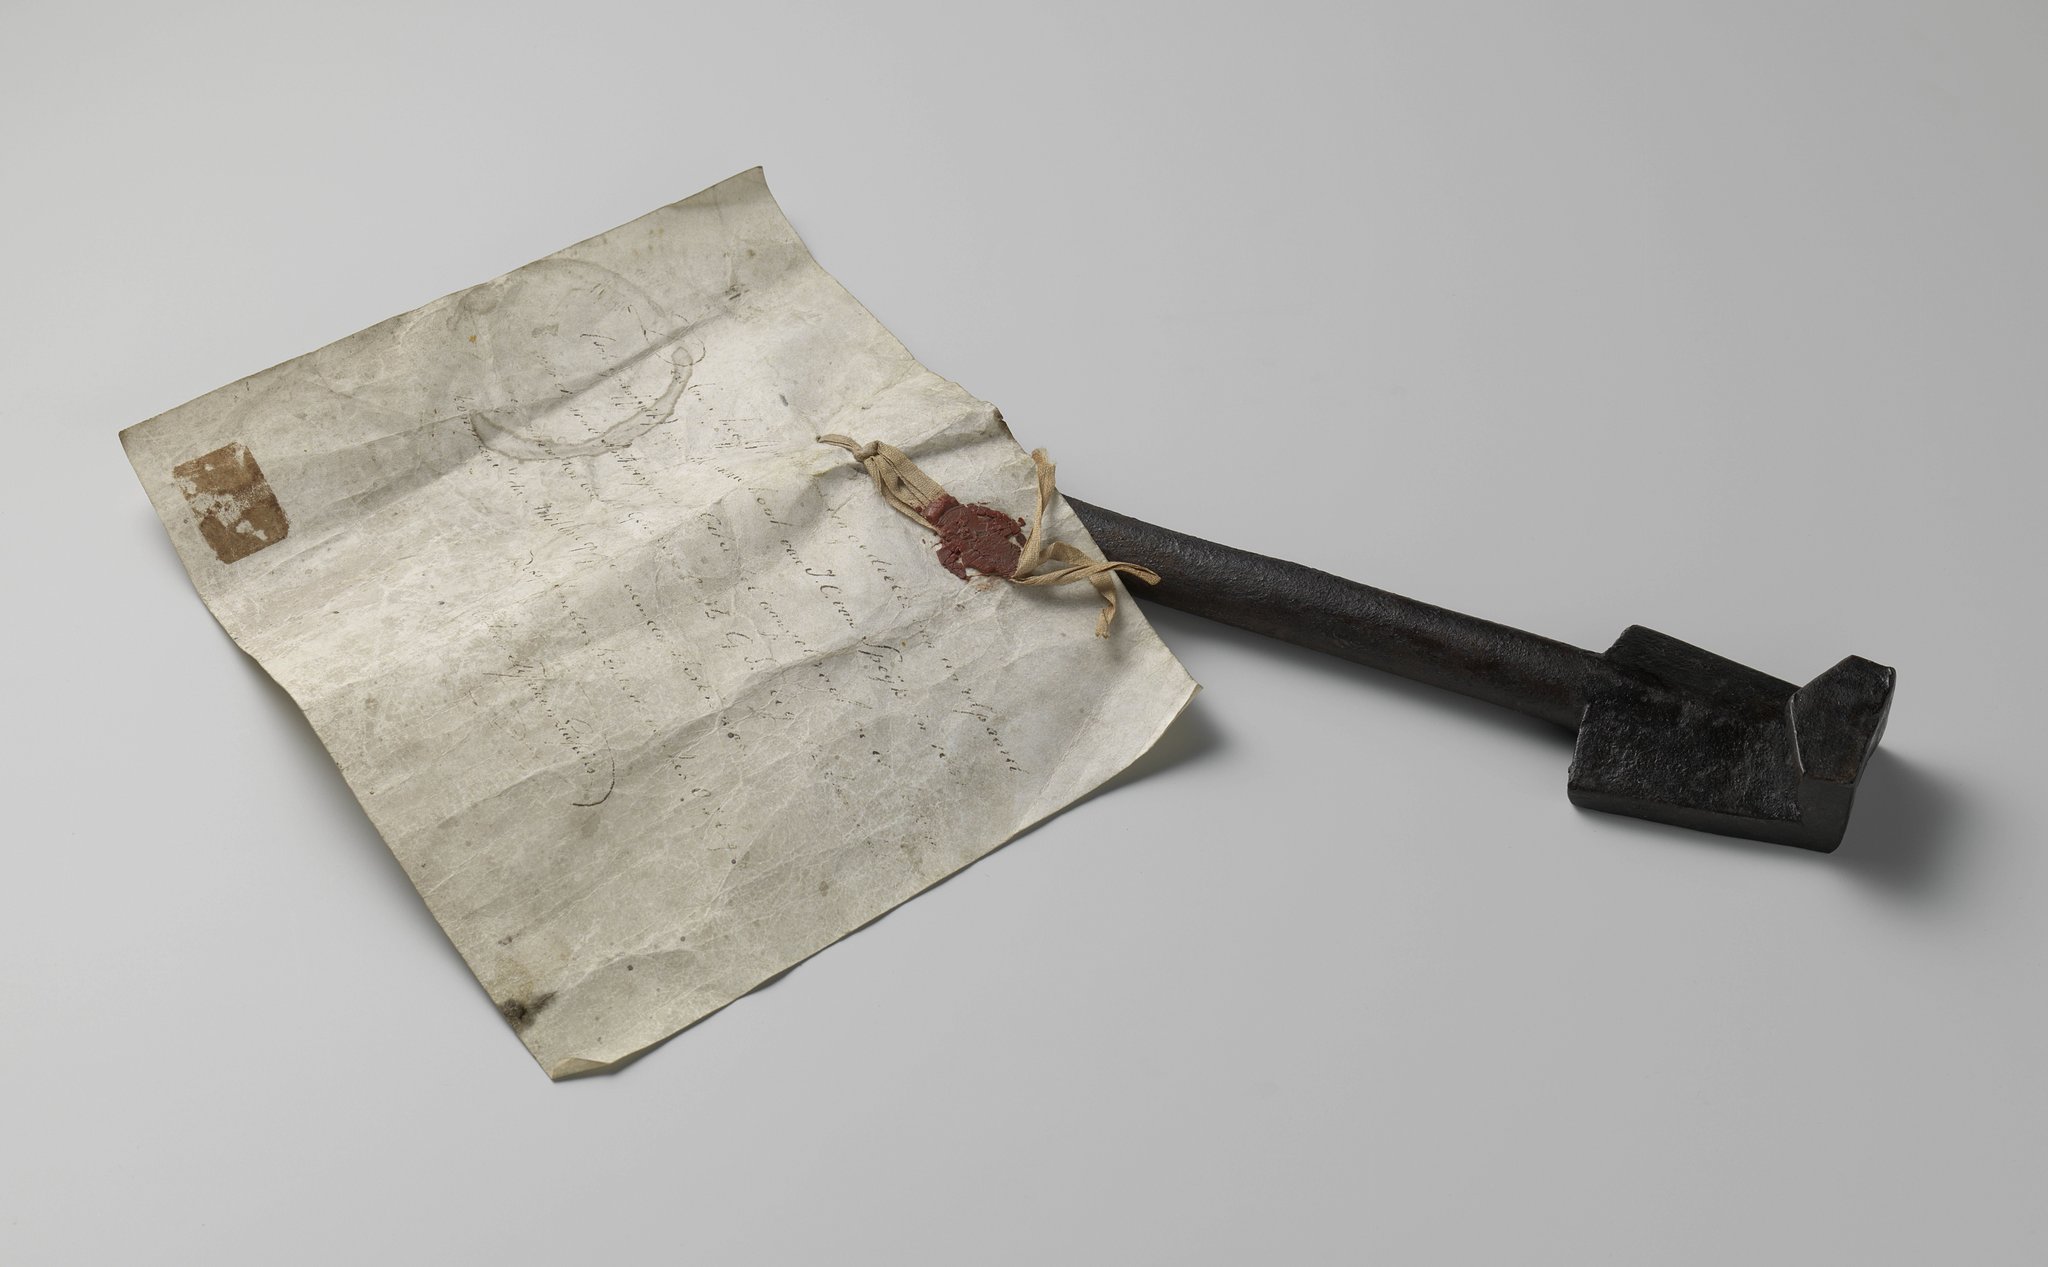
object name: wheel carriage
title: Luns van een gedeelte van een rolpaard van de kanonneerboot No.2 van J.C.J. van Speyk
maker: g.i. luipius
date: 1831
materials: iron, lacquer, linen, parchment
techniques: printing, forging, knotting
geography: netherlands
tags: antwerp, jan van speyk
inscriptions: inscription: ‘Deze lans heeft behoord ... een gedeelte van een rolpaard (scheepsaffuit) van de kanonneerboot van J.C. van Speijk in 1831 uit de stad Antwerpen op de Citadel aangebragt... van wijlen de luit Generaal H.G.S. ... kommandt der Artillerie op genoemde sterkte was.’, signature: ‘De kapitein der Artillerie van het OI leger G.I. van ... Luipius’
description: On 5 October 1833 the amount raised by the lottery was announced. After costs the lottery made ? 6484,98. A total of 5723 tickets had been sold and 911 prizes awarded.